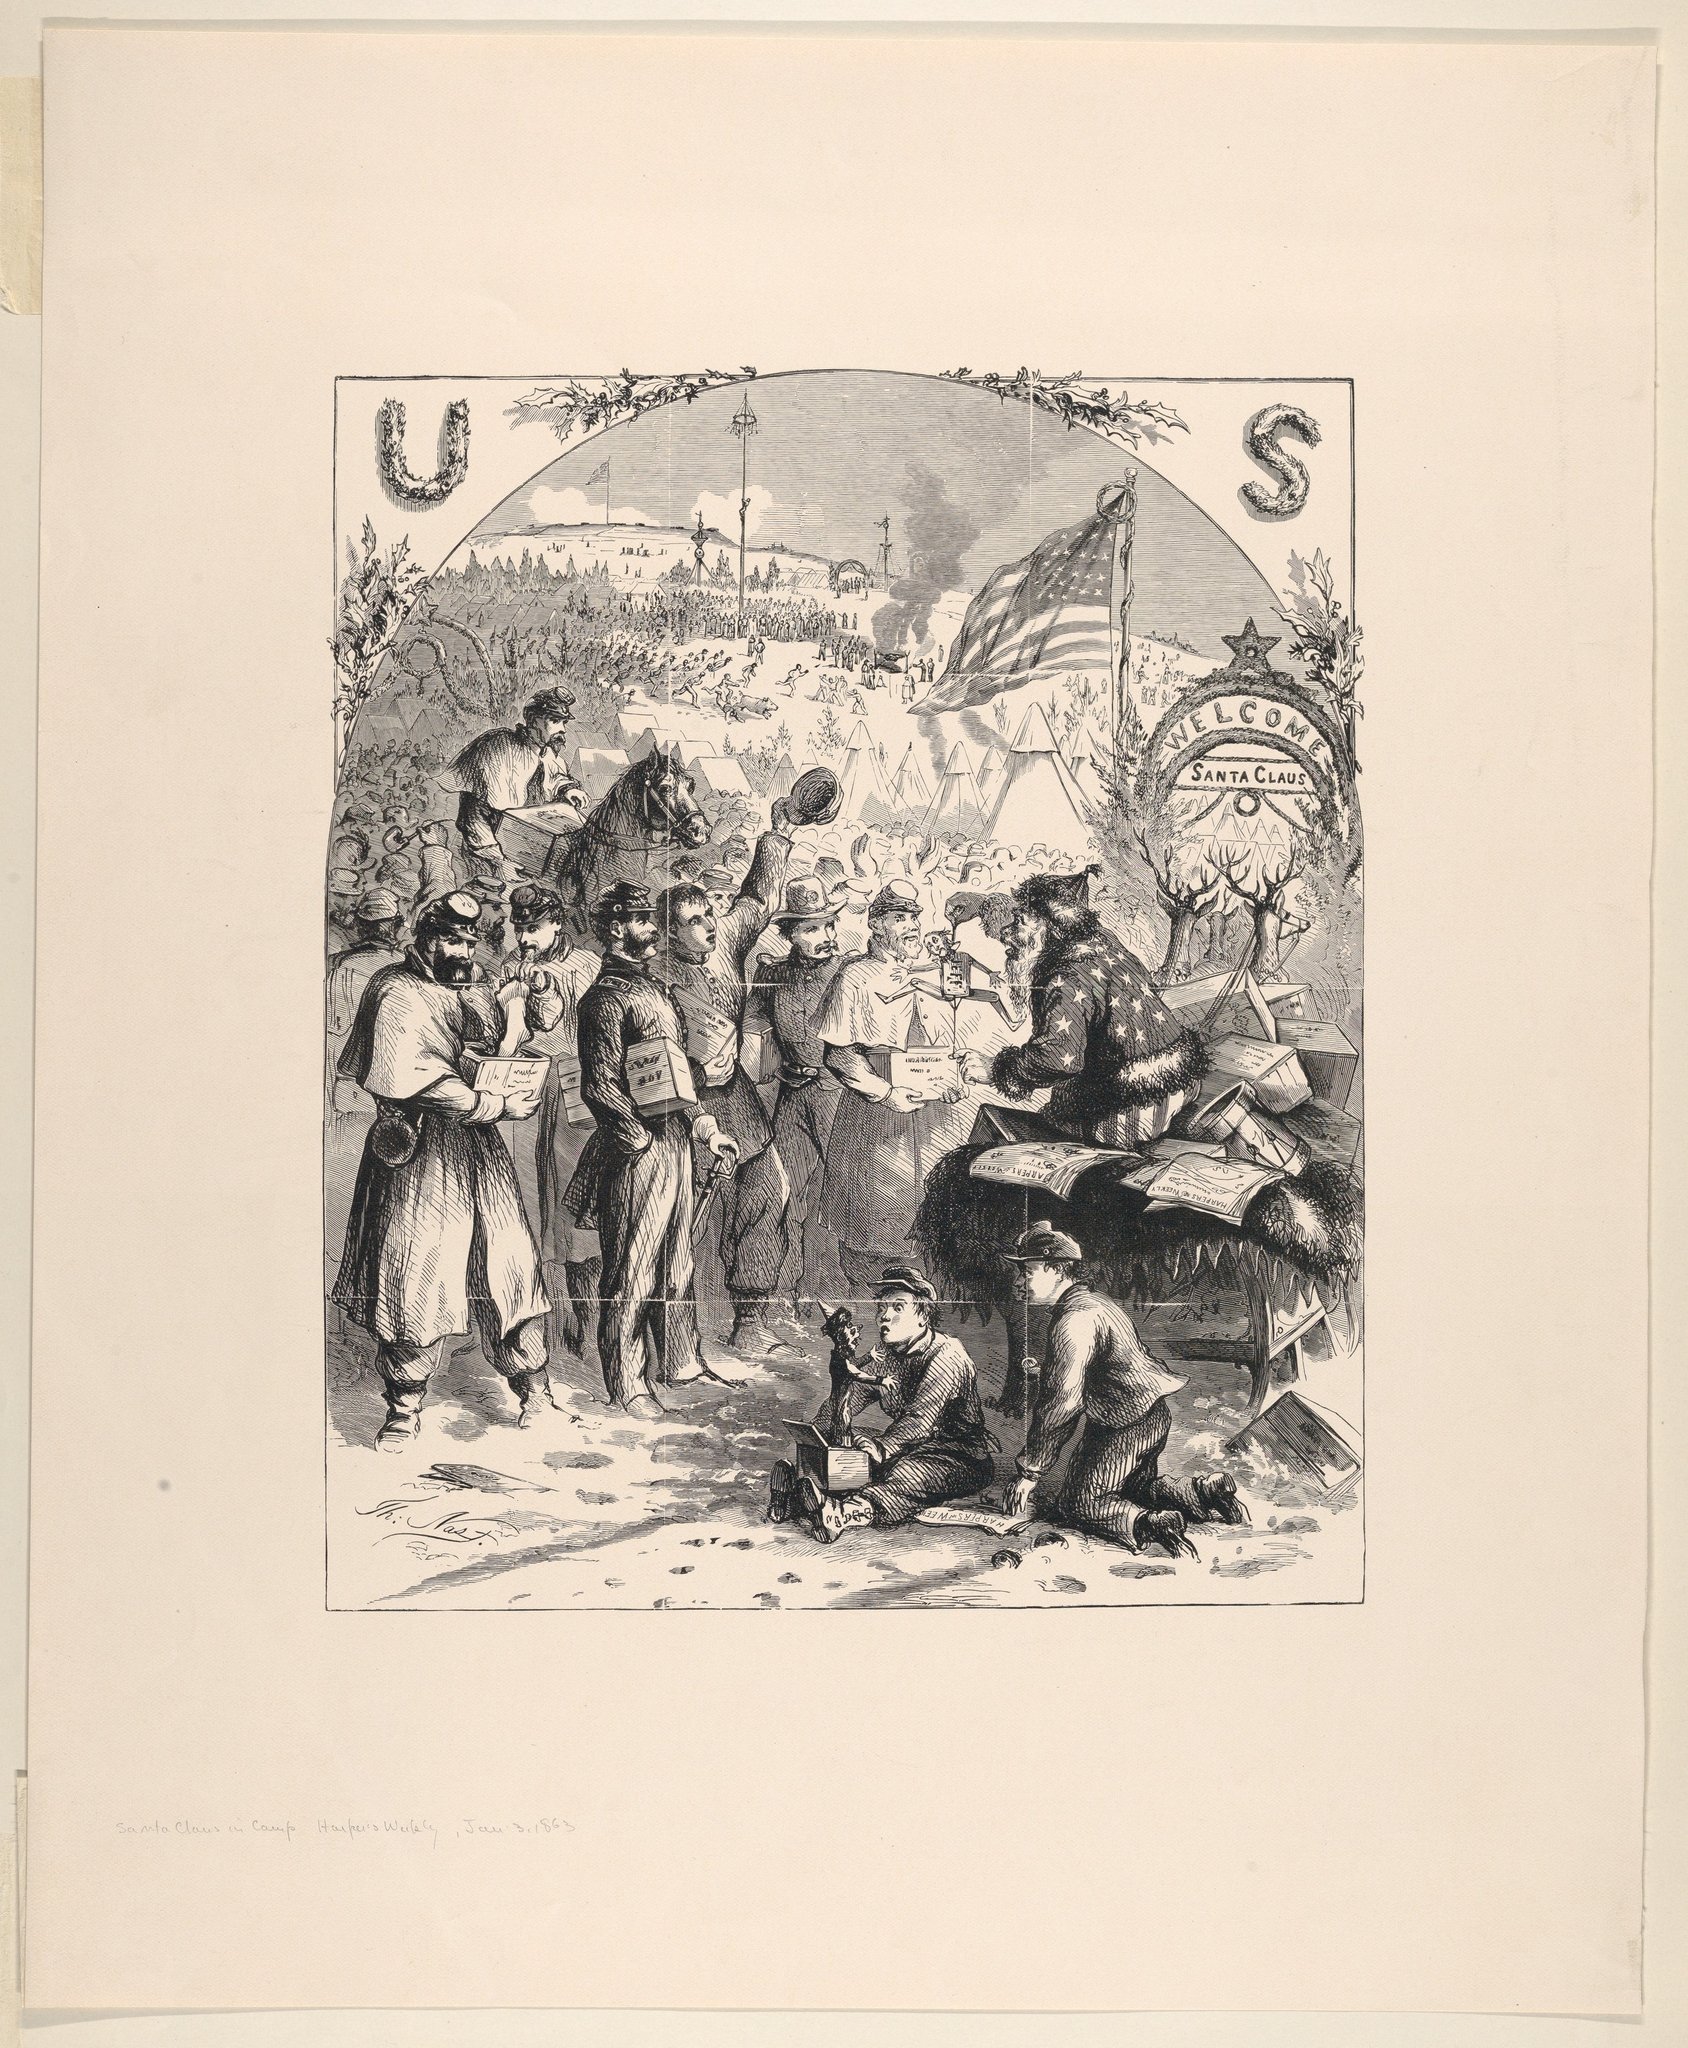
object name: print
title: Santa Claus in Camp (published in "Harper's Weekly," January 3, 1863)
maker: thomas nast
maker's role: artist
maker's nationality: american, born germany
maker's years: 1840-1902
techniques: relief print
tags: soldiers,american civil war,men,christmas,crowd,santa claus